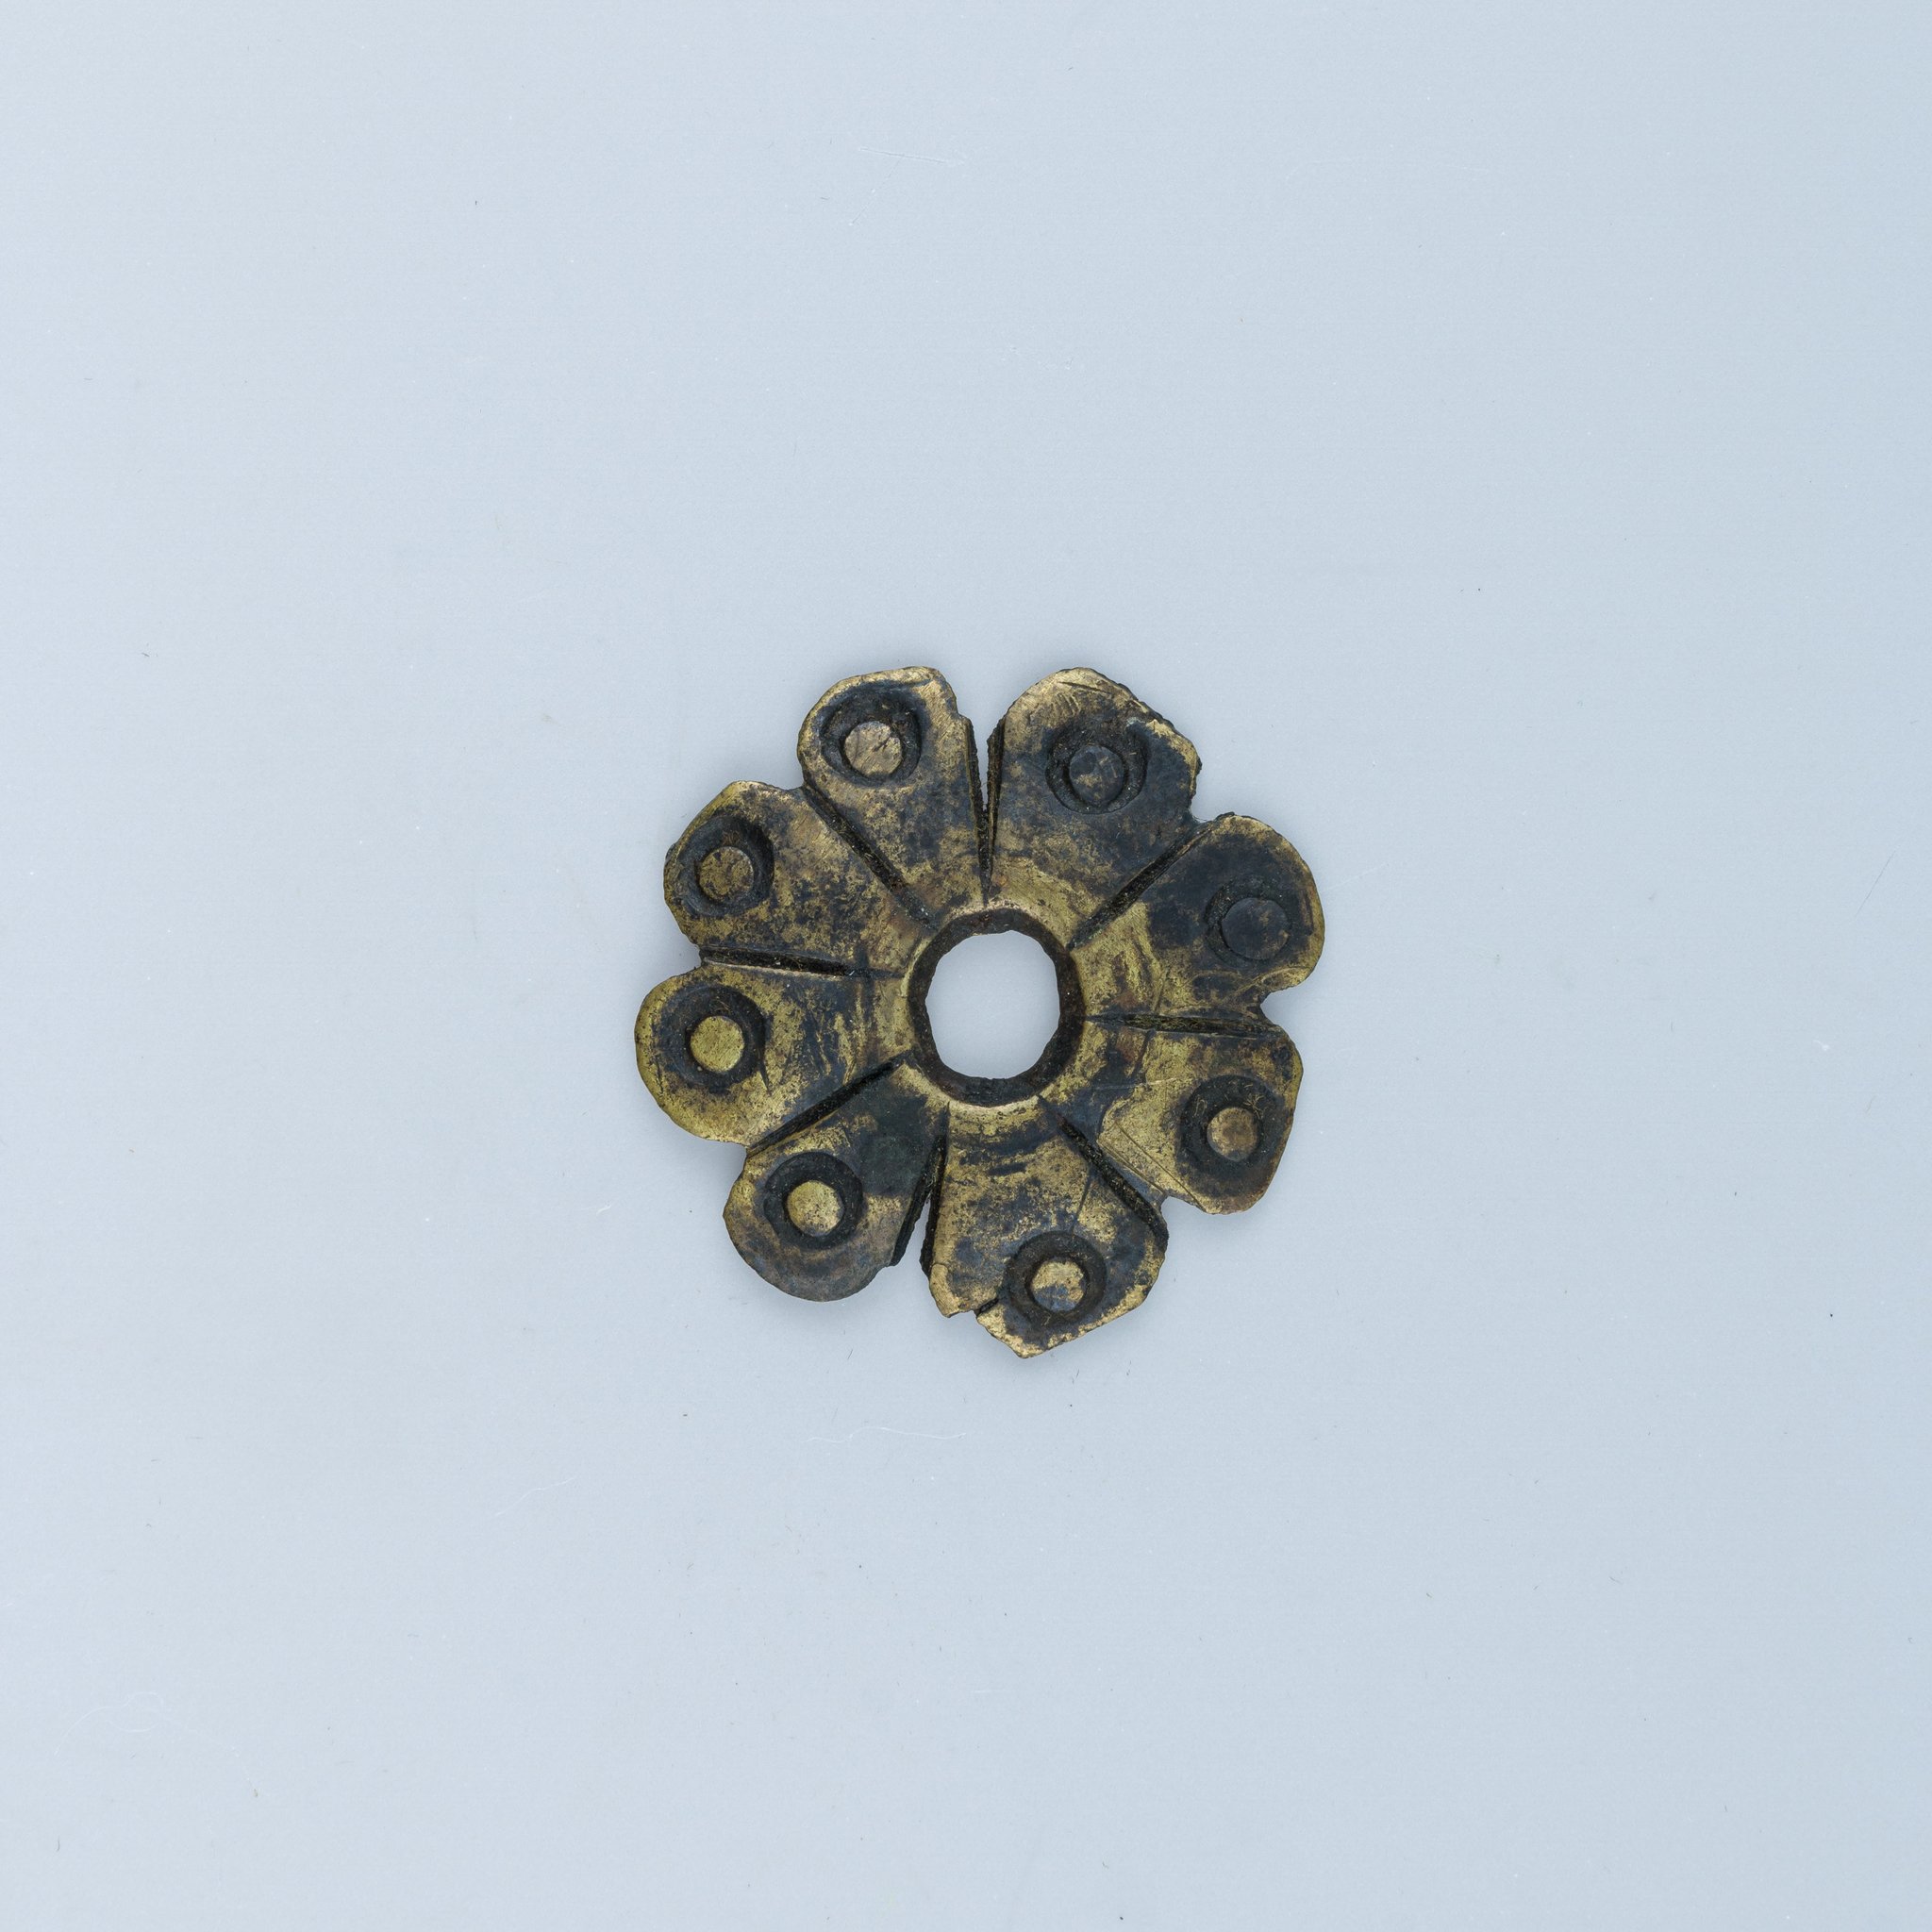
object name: rosette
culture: italian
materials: brass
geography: italy